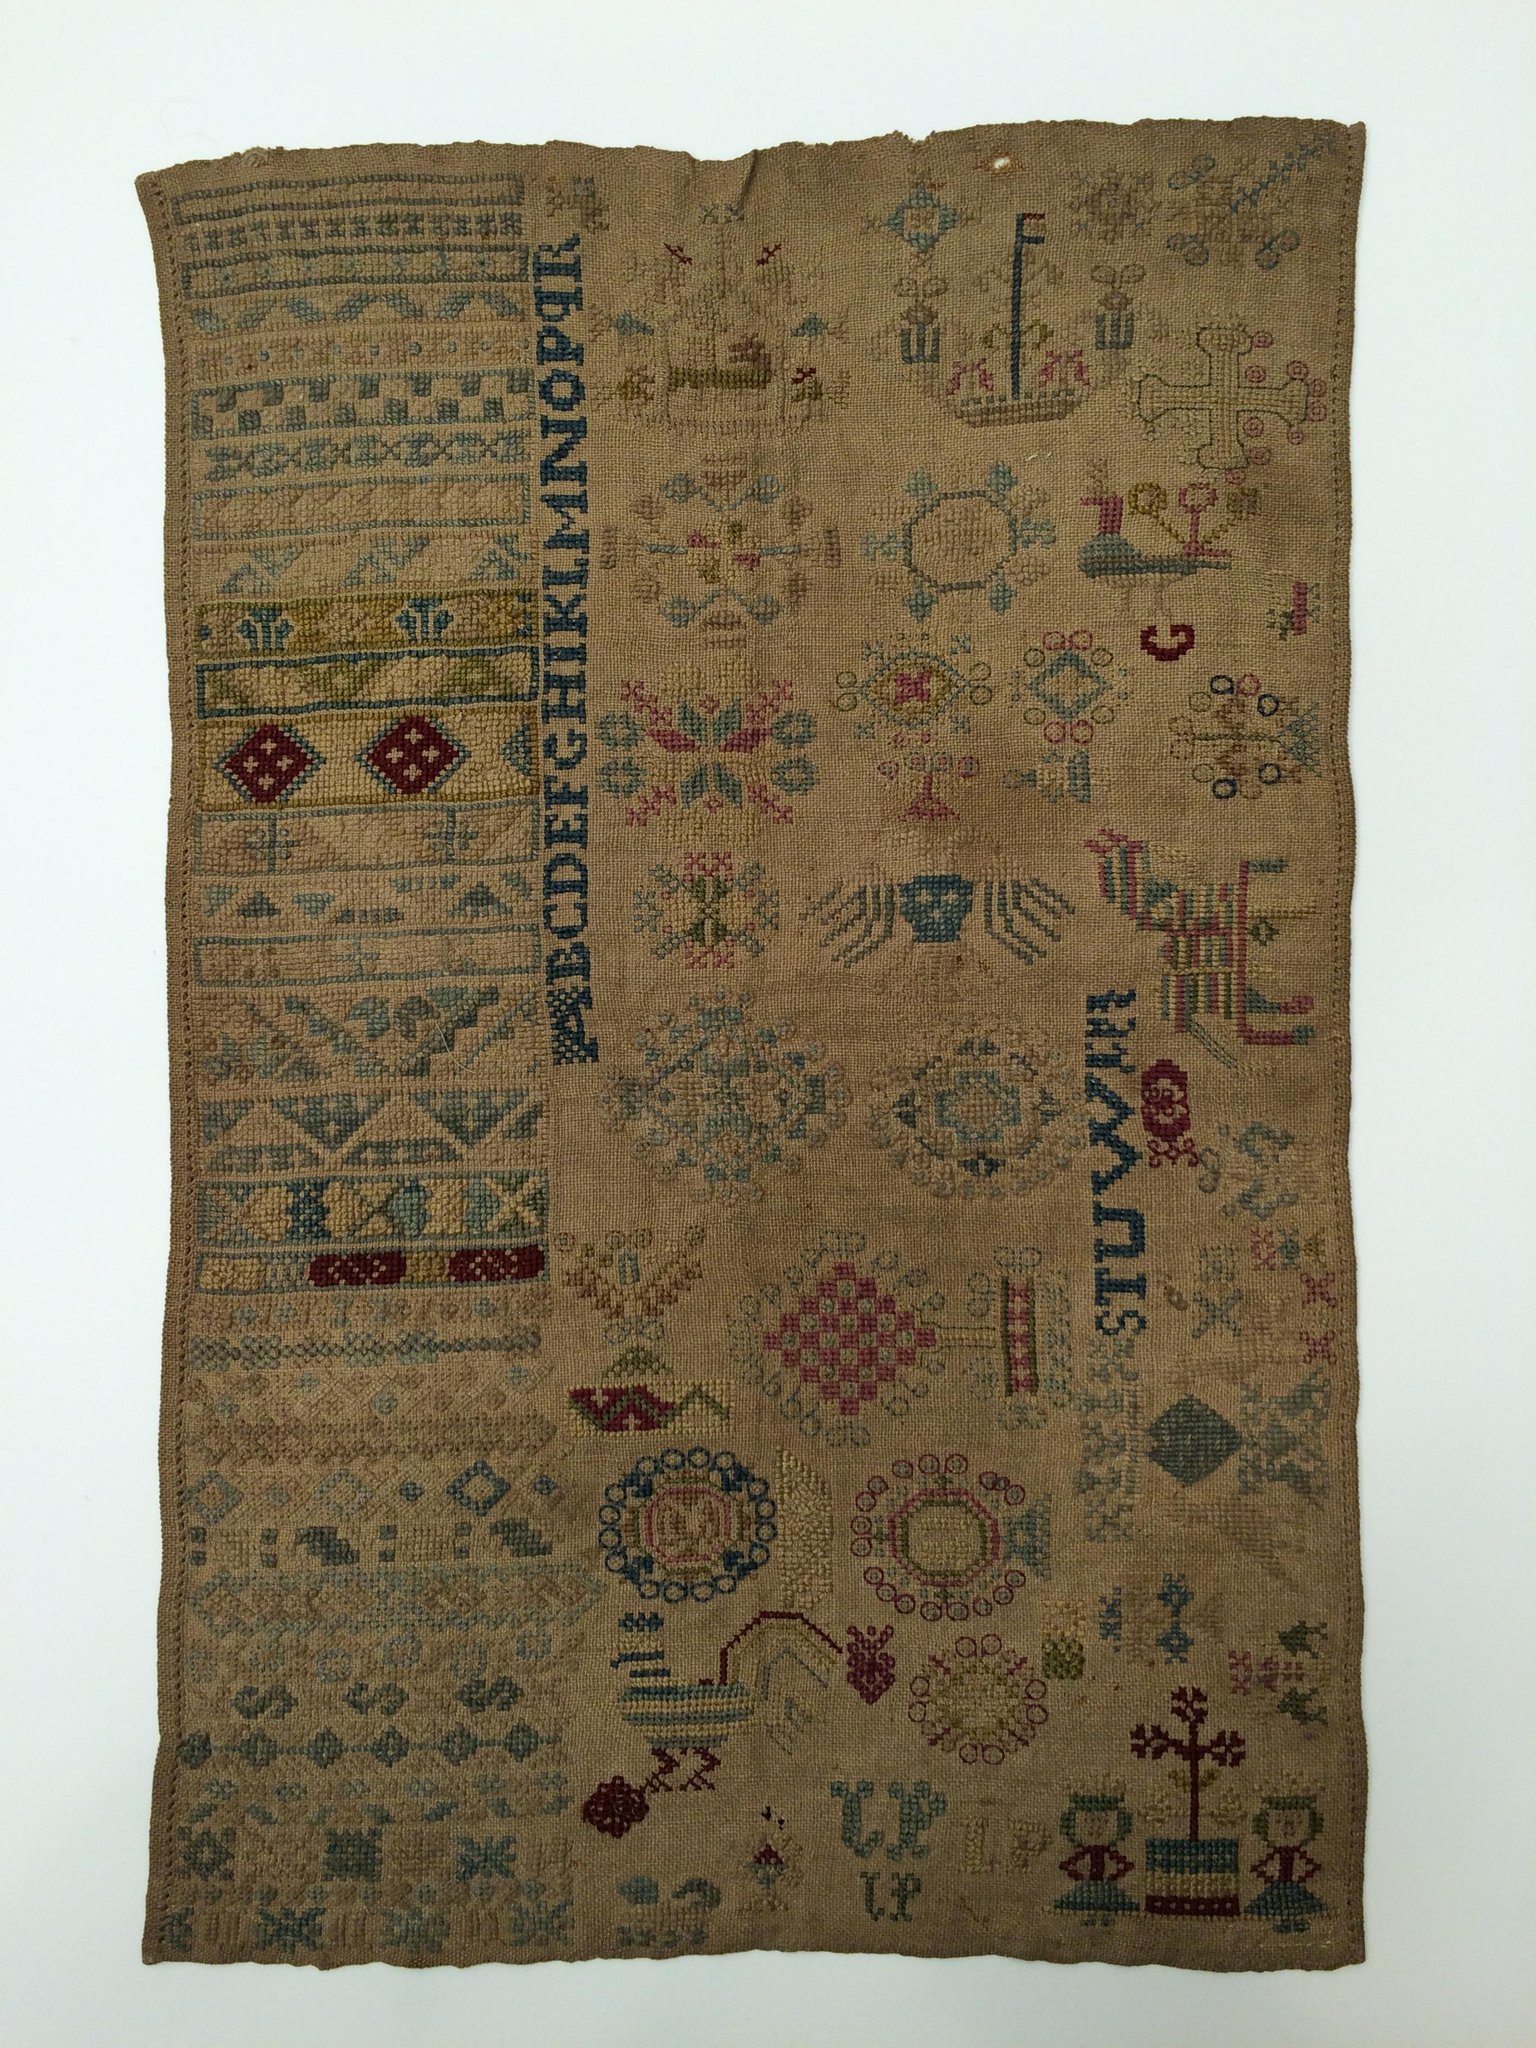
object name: sampler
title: Embroidered sampler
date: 1601-1700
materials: linen, silk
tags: roosters